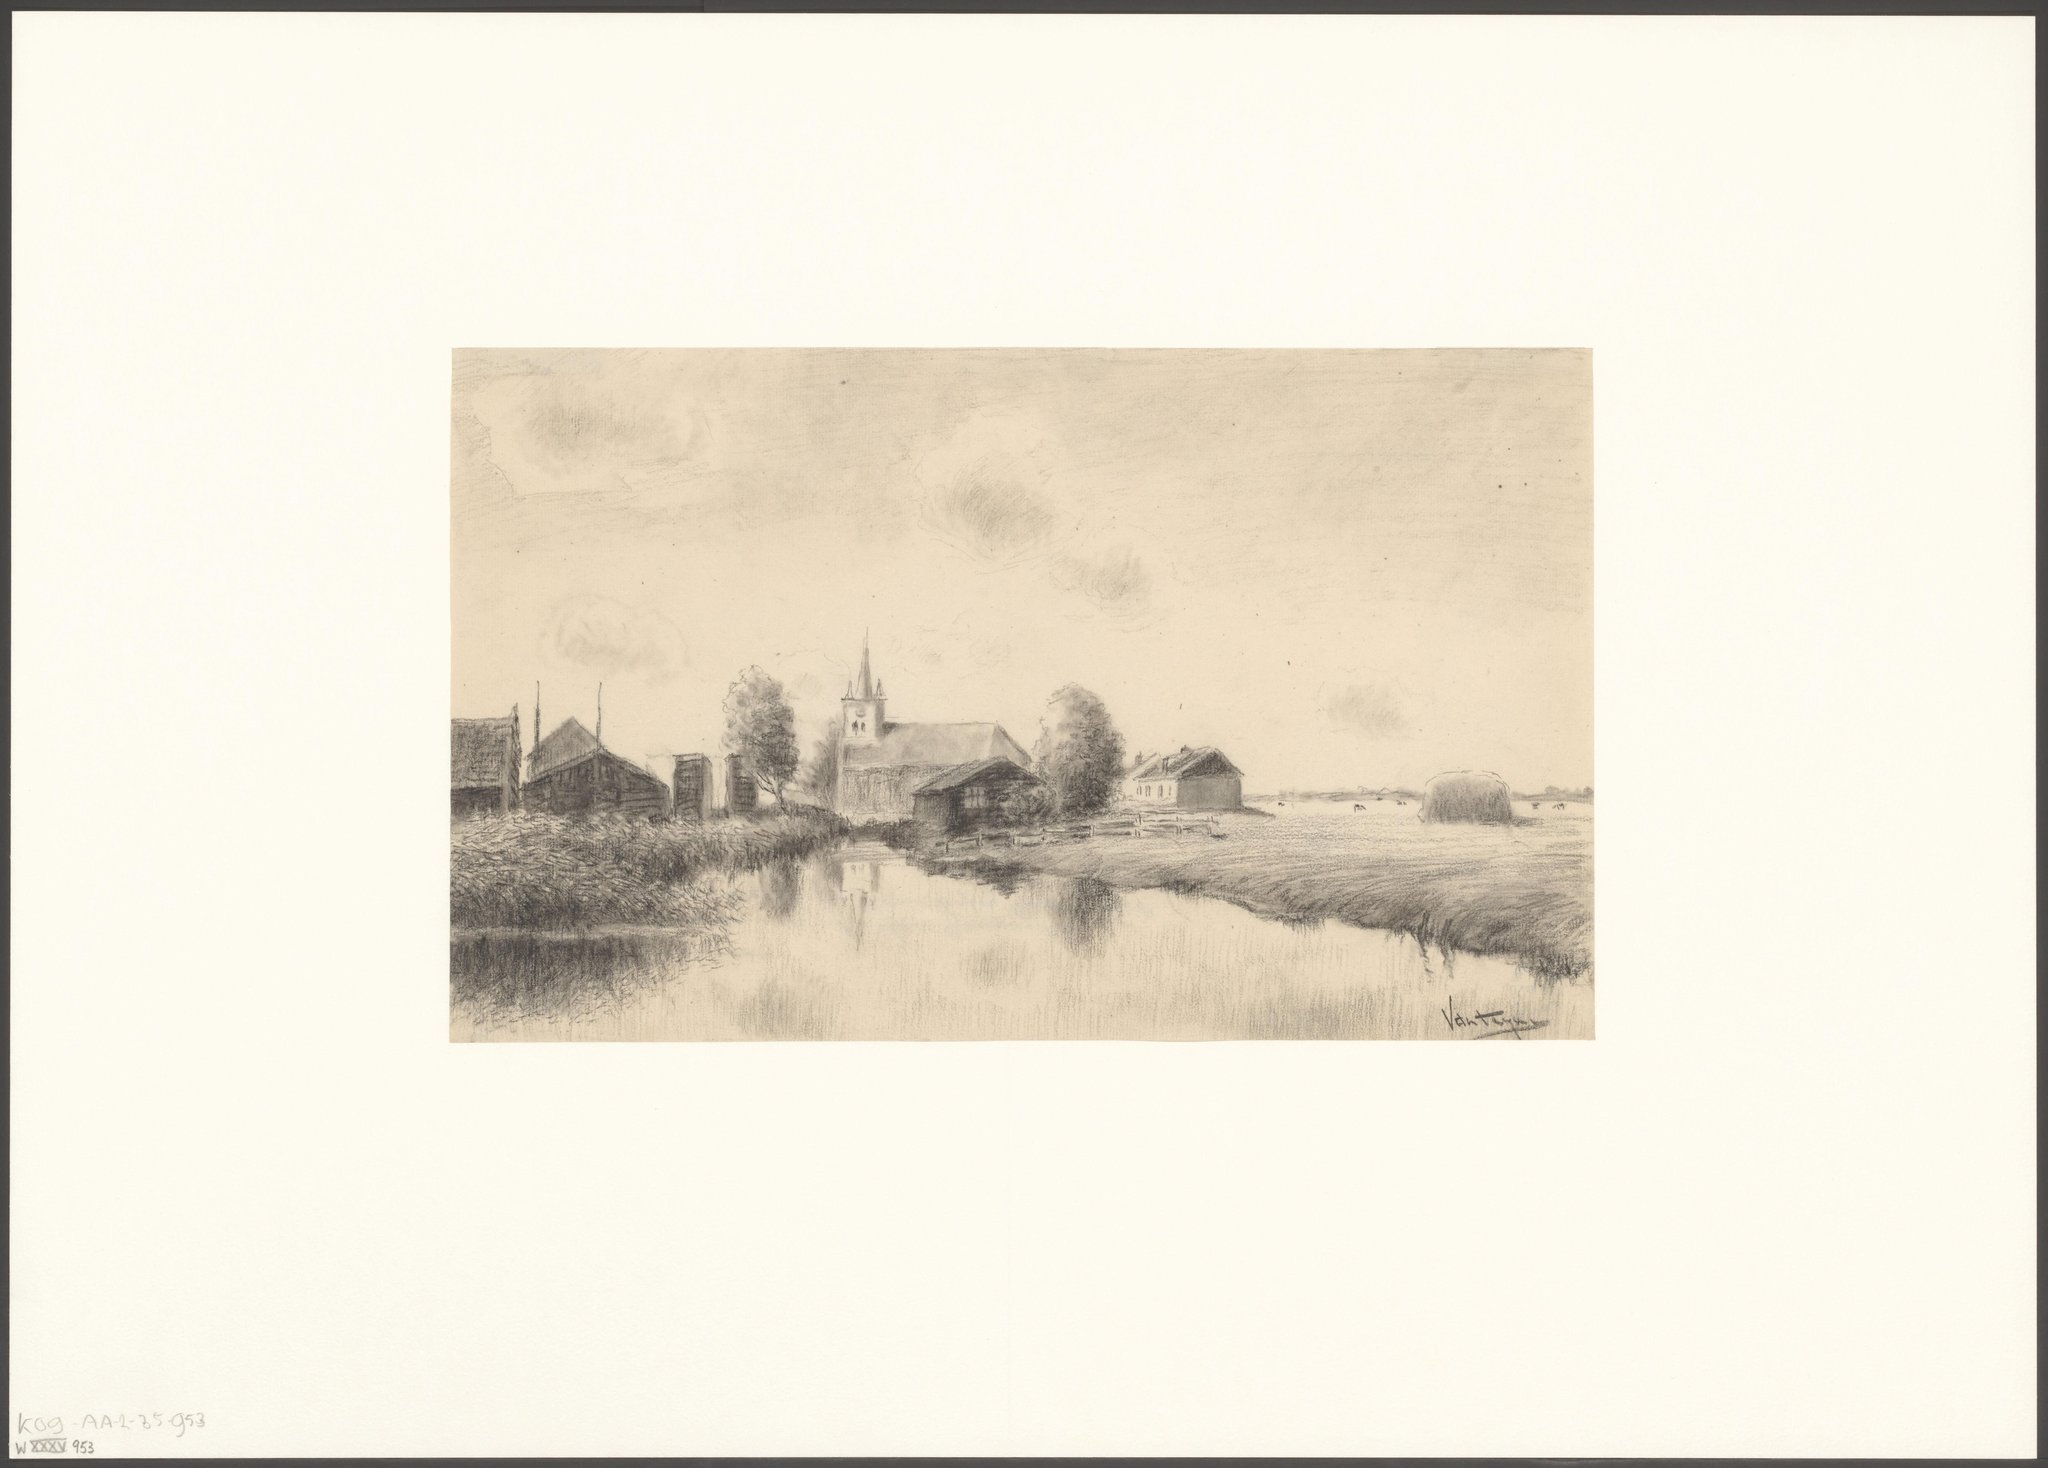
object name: drawing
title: Gezicht op de Schellingwouderkerk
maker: anthonie van teijn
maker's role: draughtsman, painter, print maker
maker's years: 1863-1943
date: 1928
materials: chalk, paper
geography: amsterdam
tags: canal, village, church (exterior)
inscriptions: inscription: ‘Schellingwoude / Kerk van (...) Ransdorp G[...]d. 1928’, collector's mark: Lugt 800a, signature: ‘VanTeyne’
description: Tekening binnen de Atlas Van Eck ingedeeld op wijknummer 35.